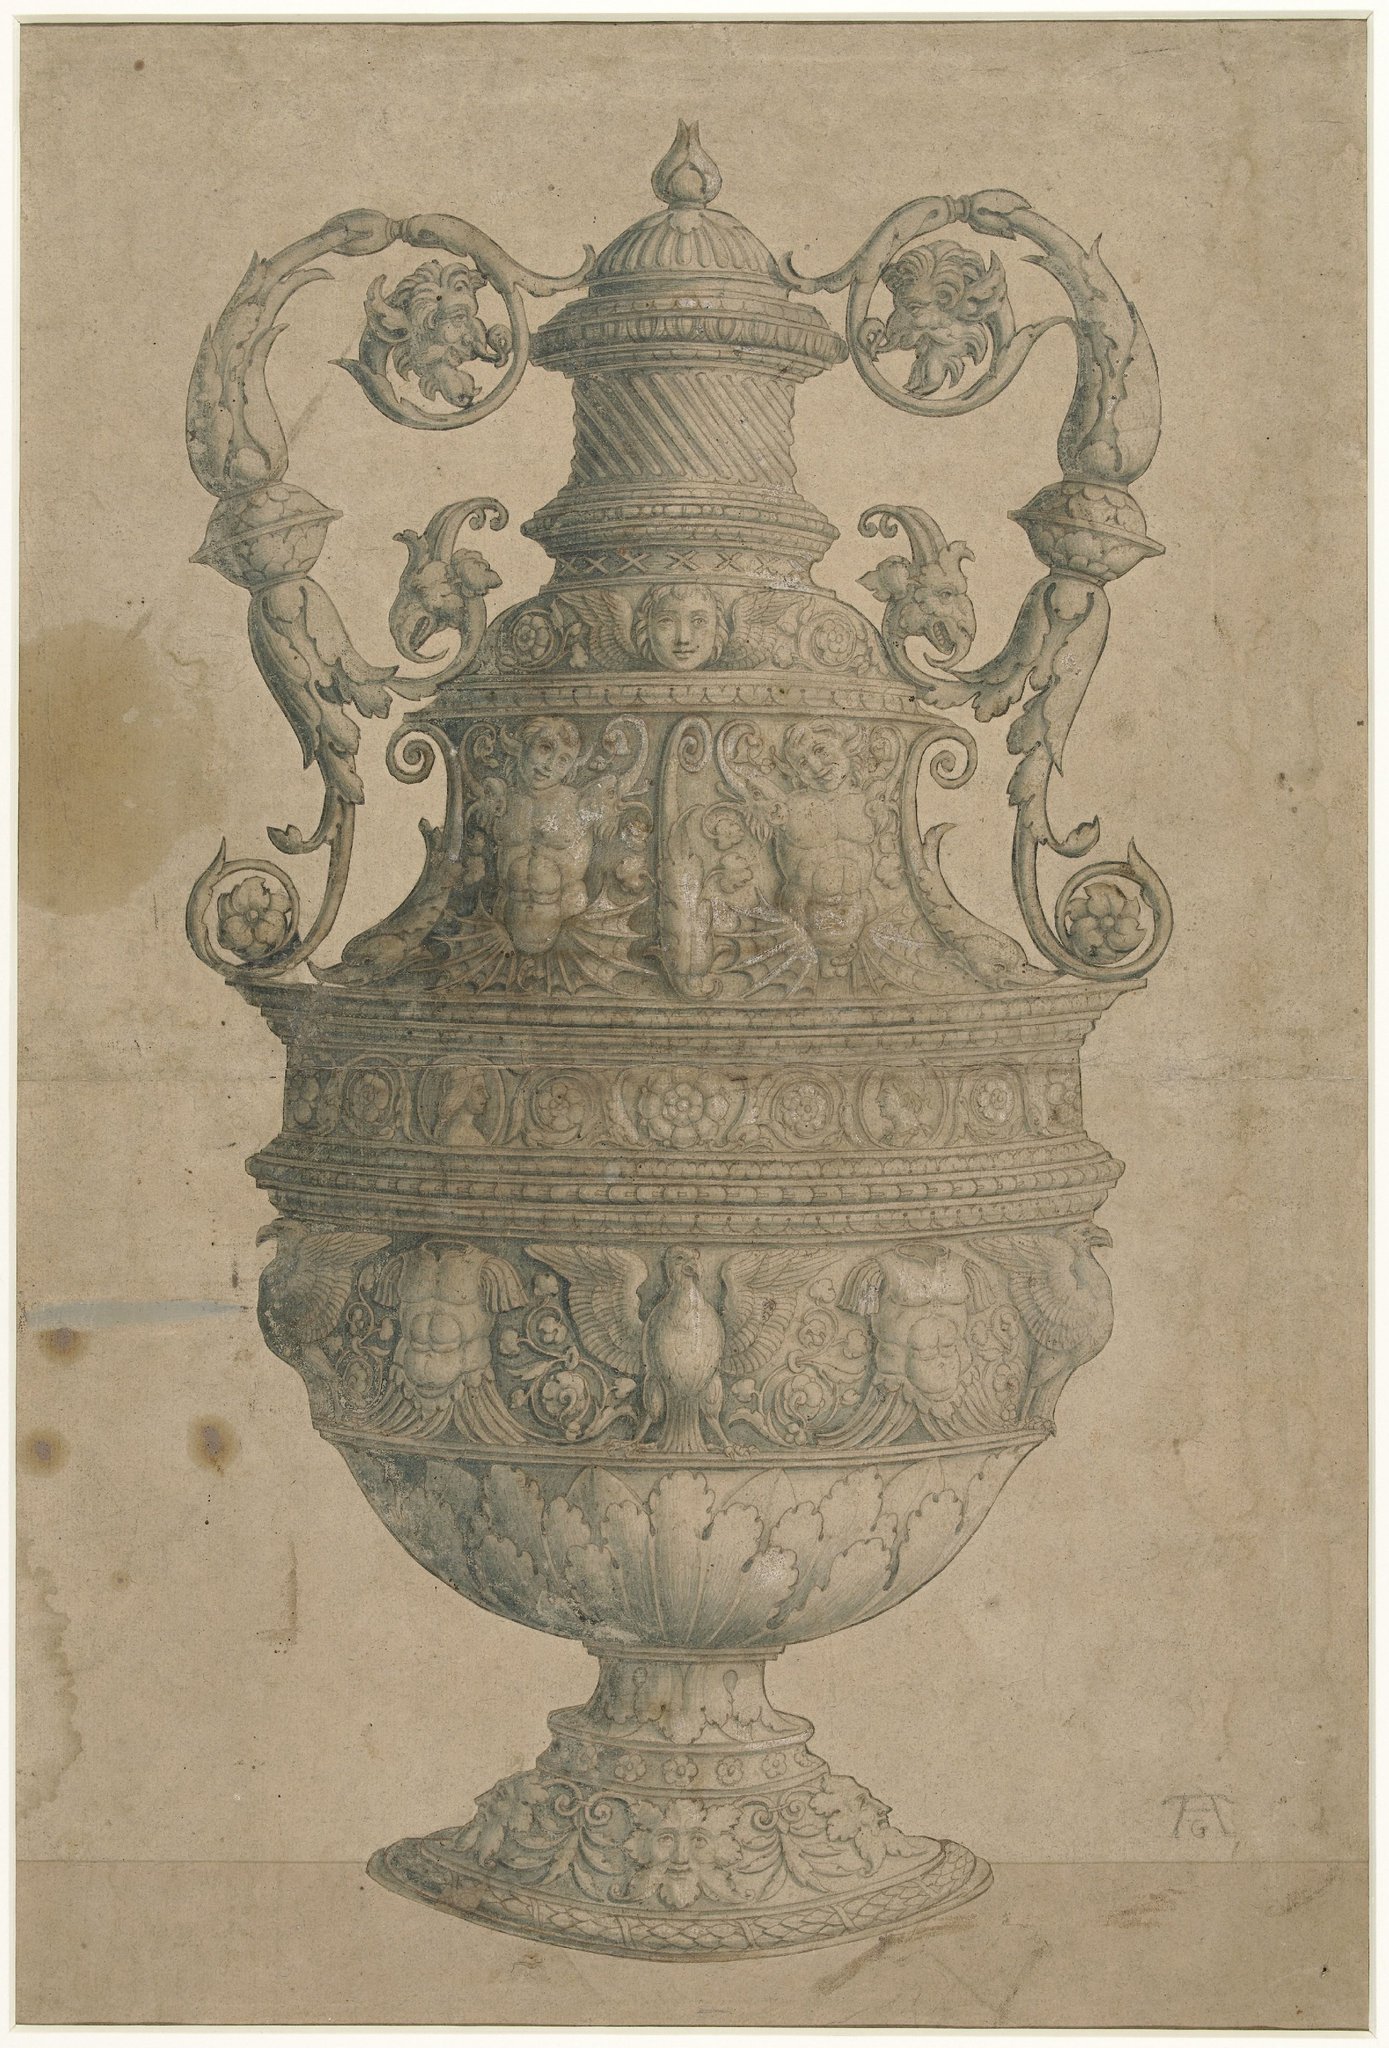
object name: drawing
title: Siervaas met meermannen tussen dolfijnen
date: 1500-1530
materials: ink, paper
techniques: brush, pen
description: P. Führing, "Un vaso monumentale del Rinascimento", in: Chiara Callegari,(red.), Gli affanni del collezionista, Padova 2003, p.45-53, afb.1-8, pp. 222-229